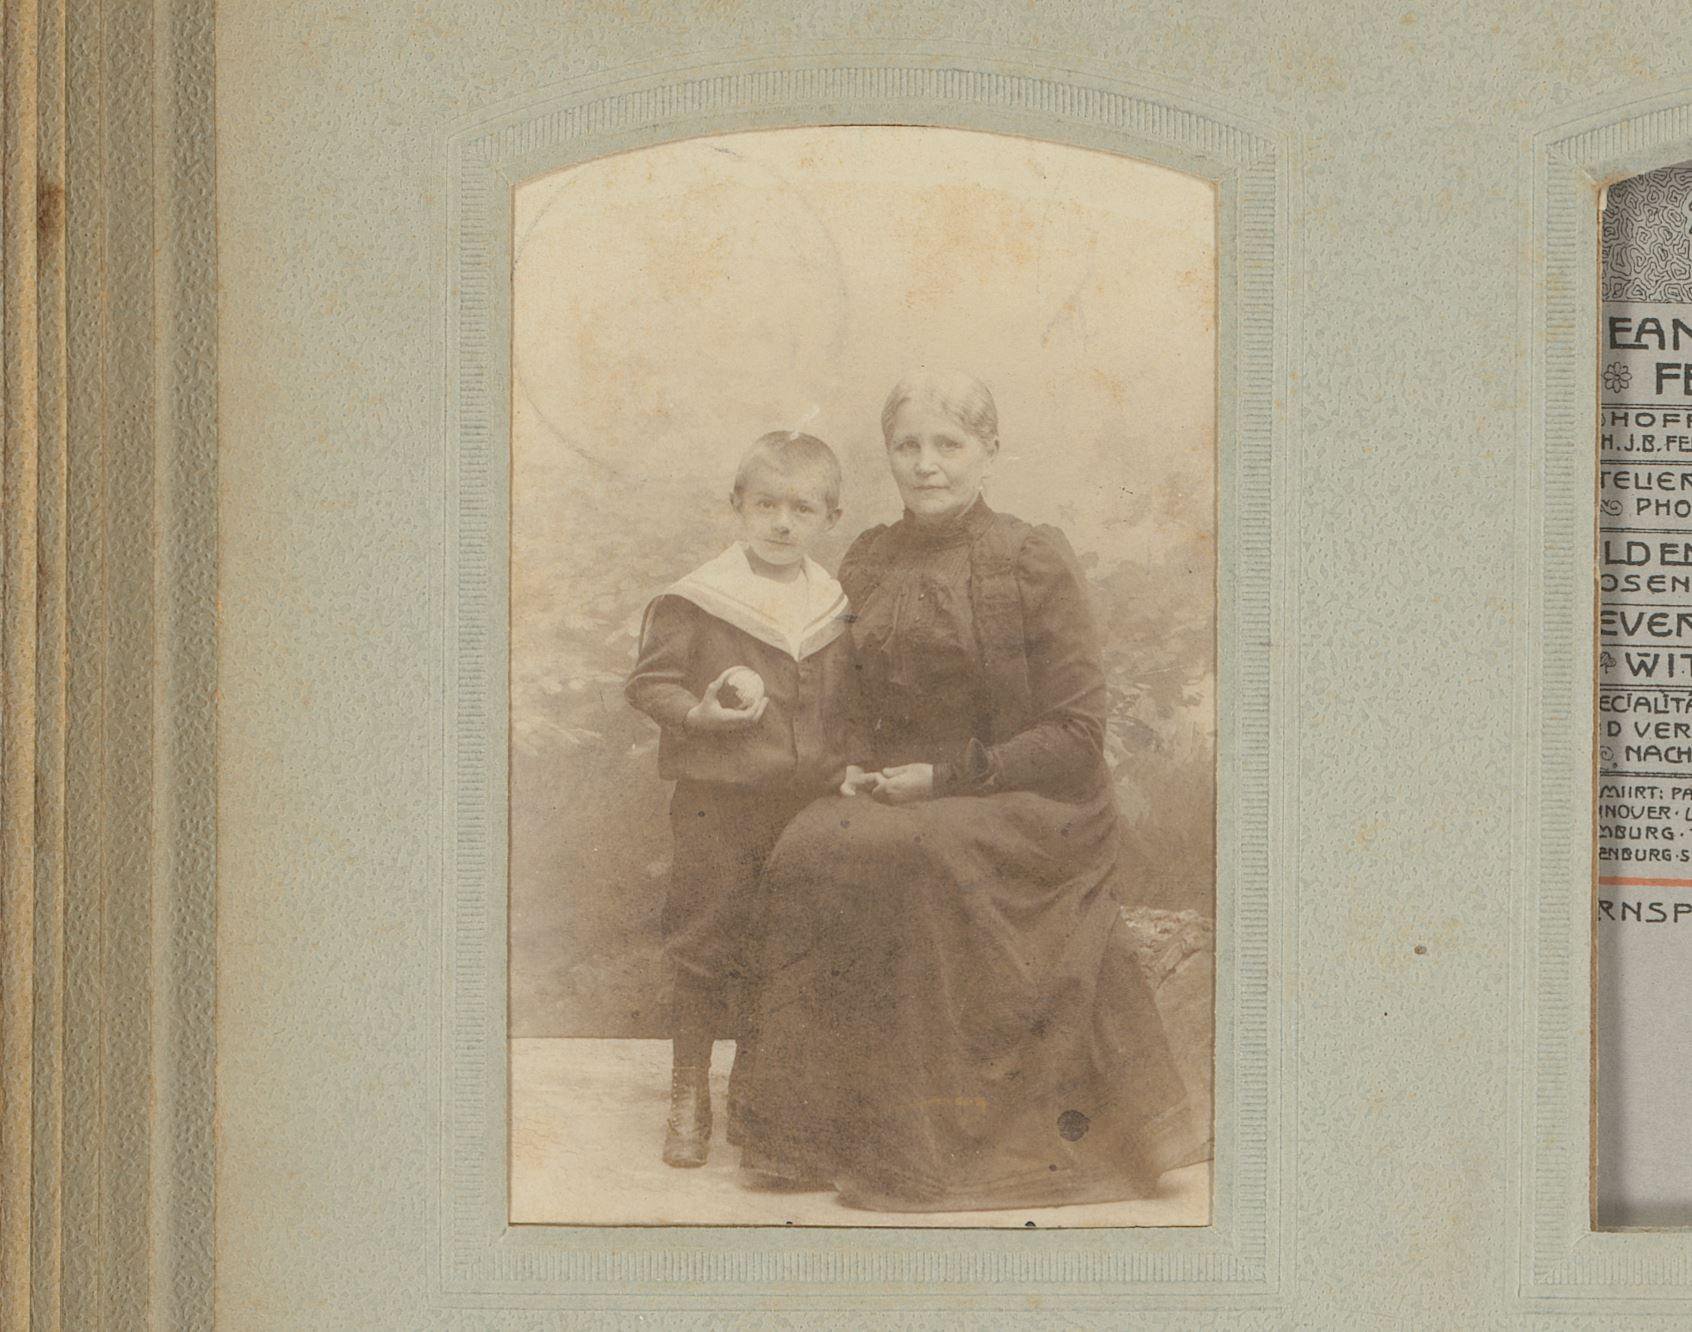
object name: album leaf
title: Portret van een onbekende oude vrouw en een jongen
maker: Anonymous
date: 1890-1915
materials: paper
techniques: gelatin silver print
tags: ensemble of pieces of clothing: sailor suit, boy (child between toddler and youth), old woman, anonymous historical person portrayed